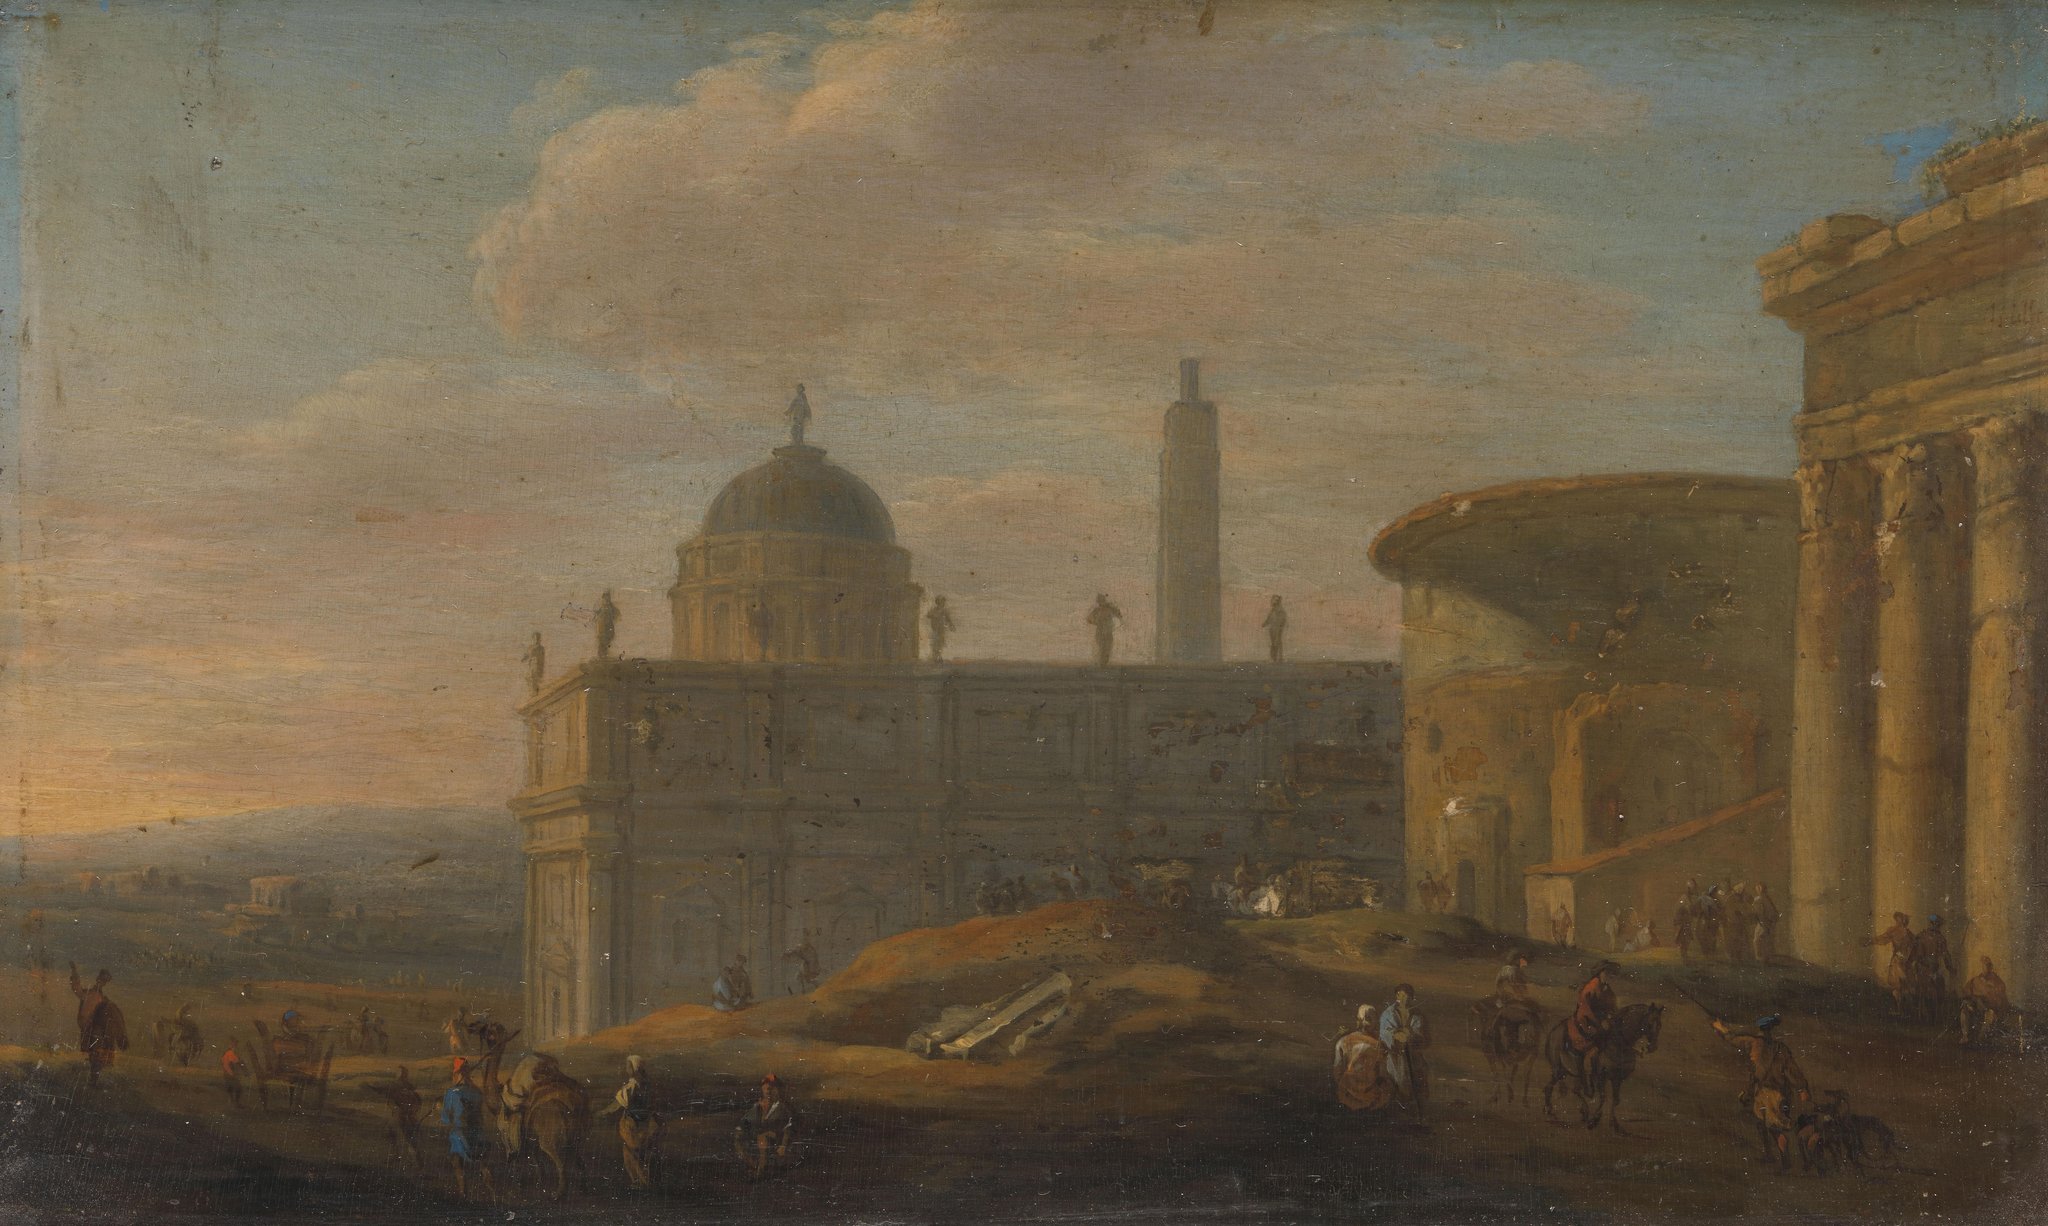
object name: painting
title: Italian city view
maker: jacob van der ulft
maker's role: draughtsman, painter, print maker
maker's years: 1627-1689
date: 1650-1689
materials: oil, panel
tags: church (exterior), landscape with ruins, prospect of city, town panorama, silhouette of city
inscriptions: signature: ‘J. v. Ulft’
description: Italiaans stadsgezicht met verschillende antieke gebouwen: rechts de zuilen van een tempel, een rond gebouw of toren en een basiliek met beelden en een koepel. Pendant van SK-A-419.